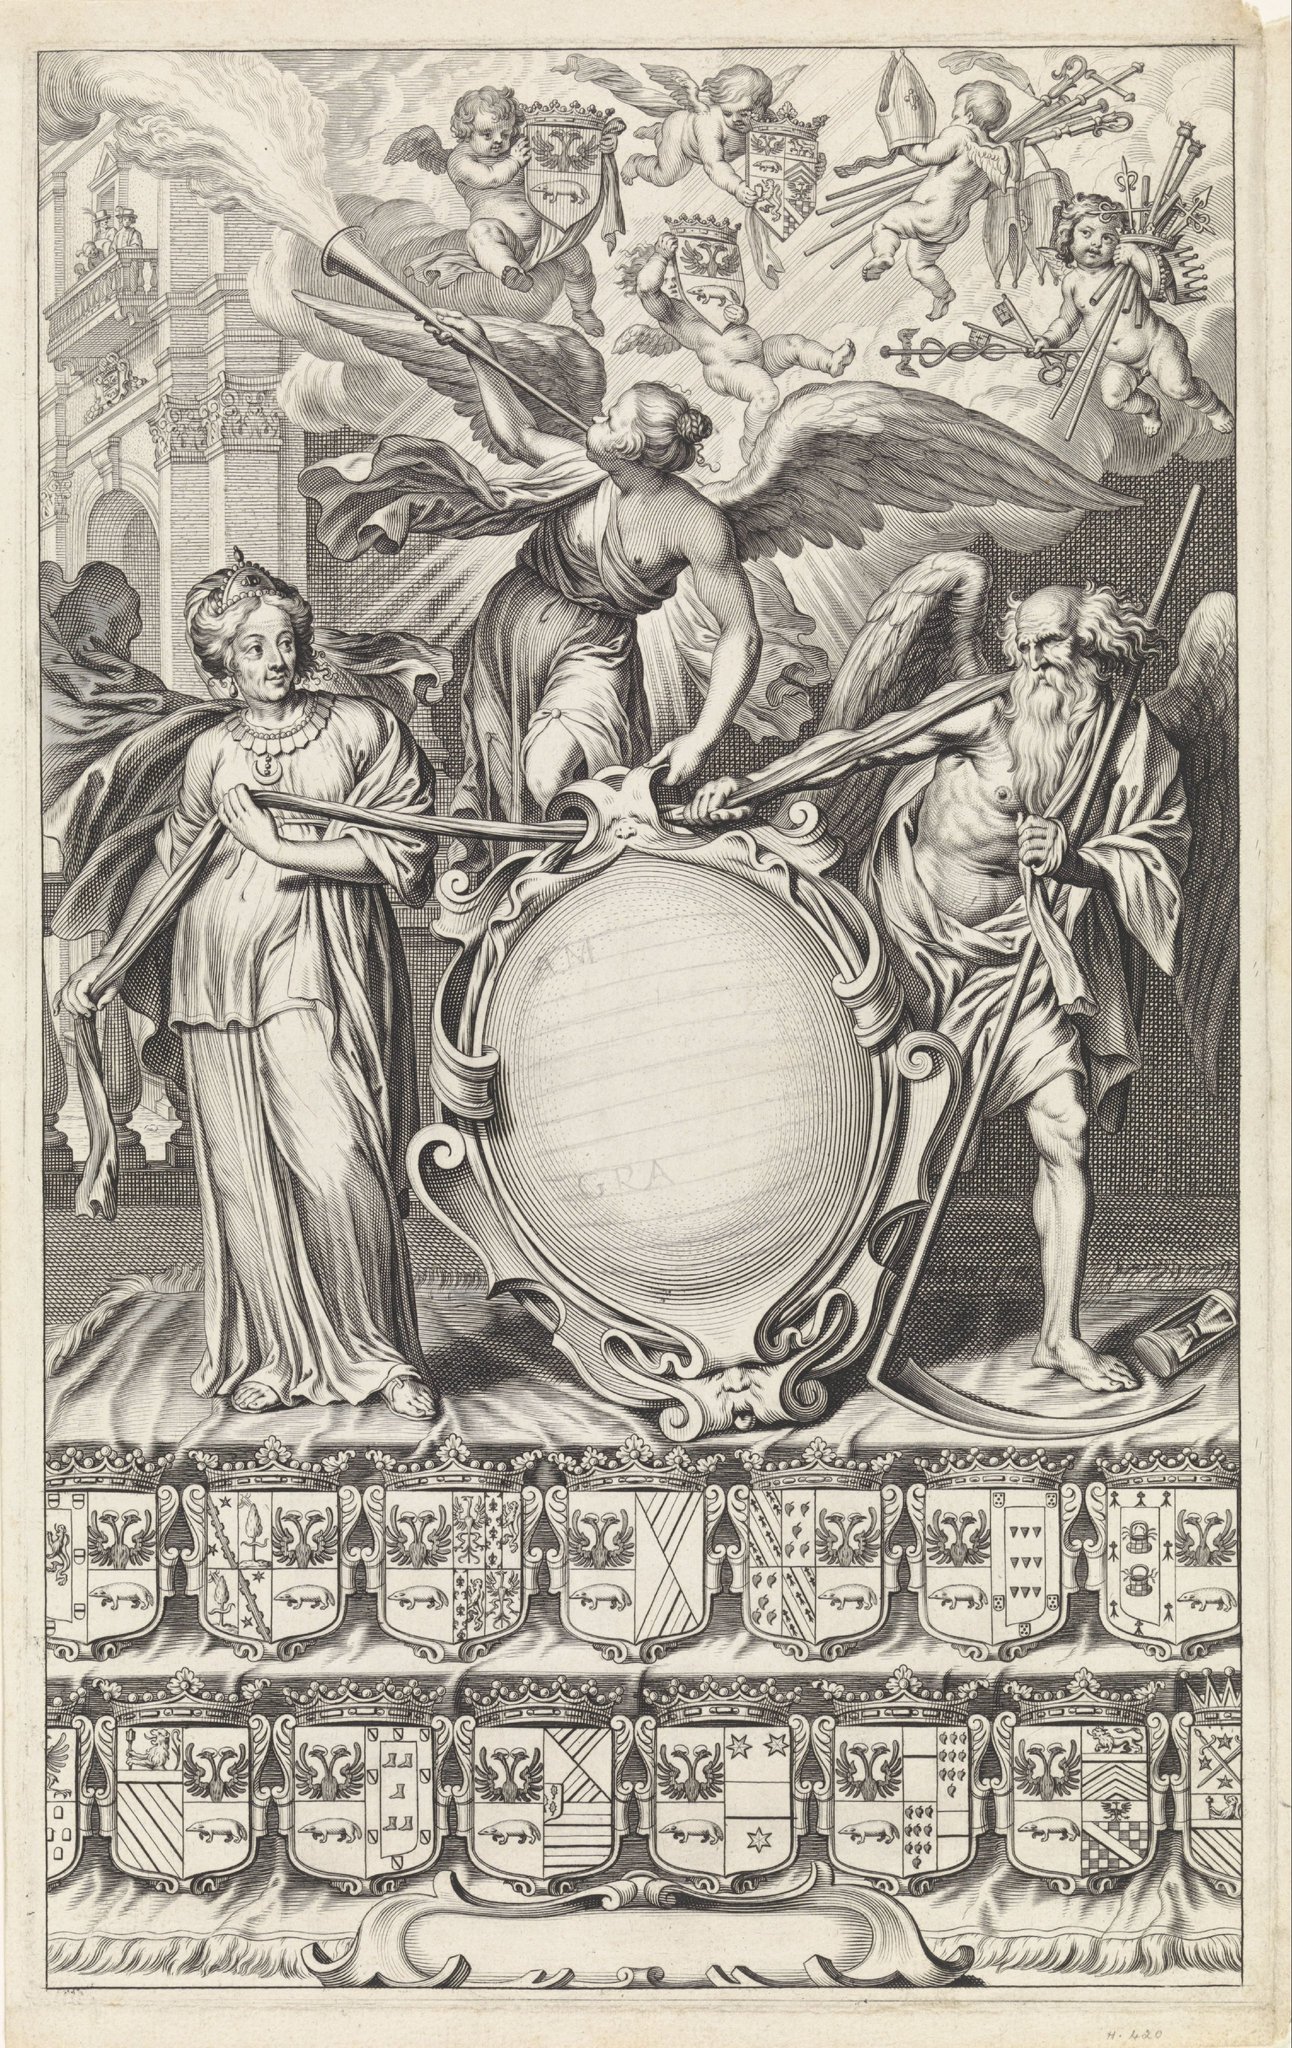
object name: print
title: Wapenschilden van de familie Tassis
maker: michel natalis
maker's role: print maker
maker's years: 1610-1668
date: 1620-1668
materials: paper, pencil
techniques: engraving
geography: liège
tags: 'historia'; 'historia' (ripa), fame; 'fama', 'fama buona', 'fama chiara' (ripa), father time, man with wings and scythe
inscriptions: collector's mark: Lugt 2228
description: In het midden blaast de personificatie van Faam, een gevleugelde vrouw, op haar trompet. Samen met Geschiedenis, een vrouw met kroon in het haar, en Vadertje Tijd, met zeis en zandloper, toont zij een leeg blazoen. Rechtsboven vliegen putti met wapenschilden en bundels attributen, waaronder kerkelijke mijters, staffen, kronen en sleutels, maar ook de Caduseus. Linksboven een gebouw, met toeschouwers op het balkon. Onderaan twee rijen van in totaal vijftien wapenschilden, vermoedelijk van de familie Tassis.